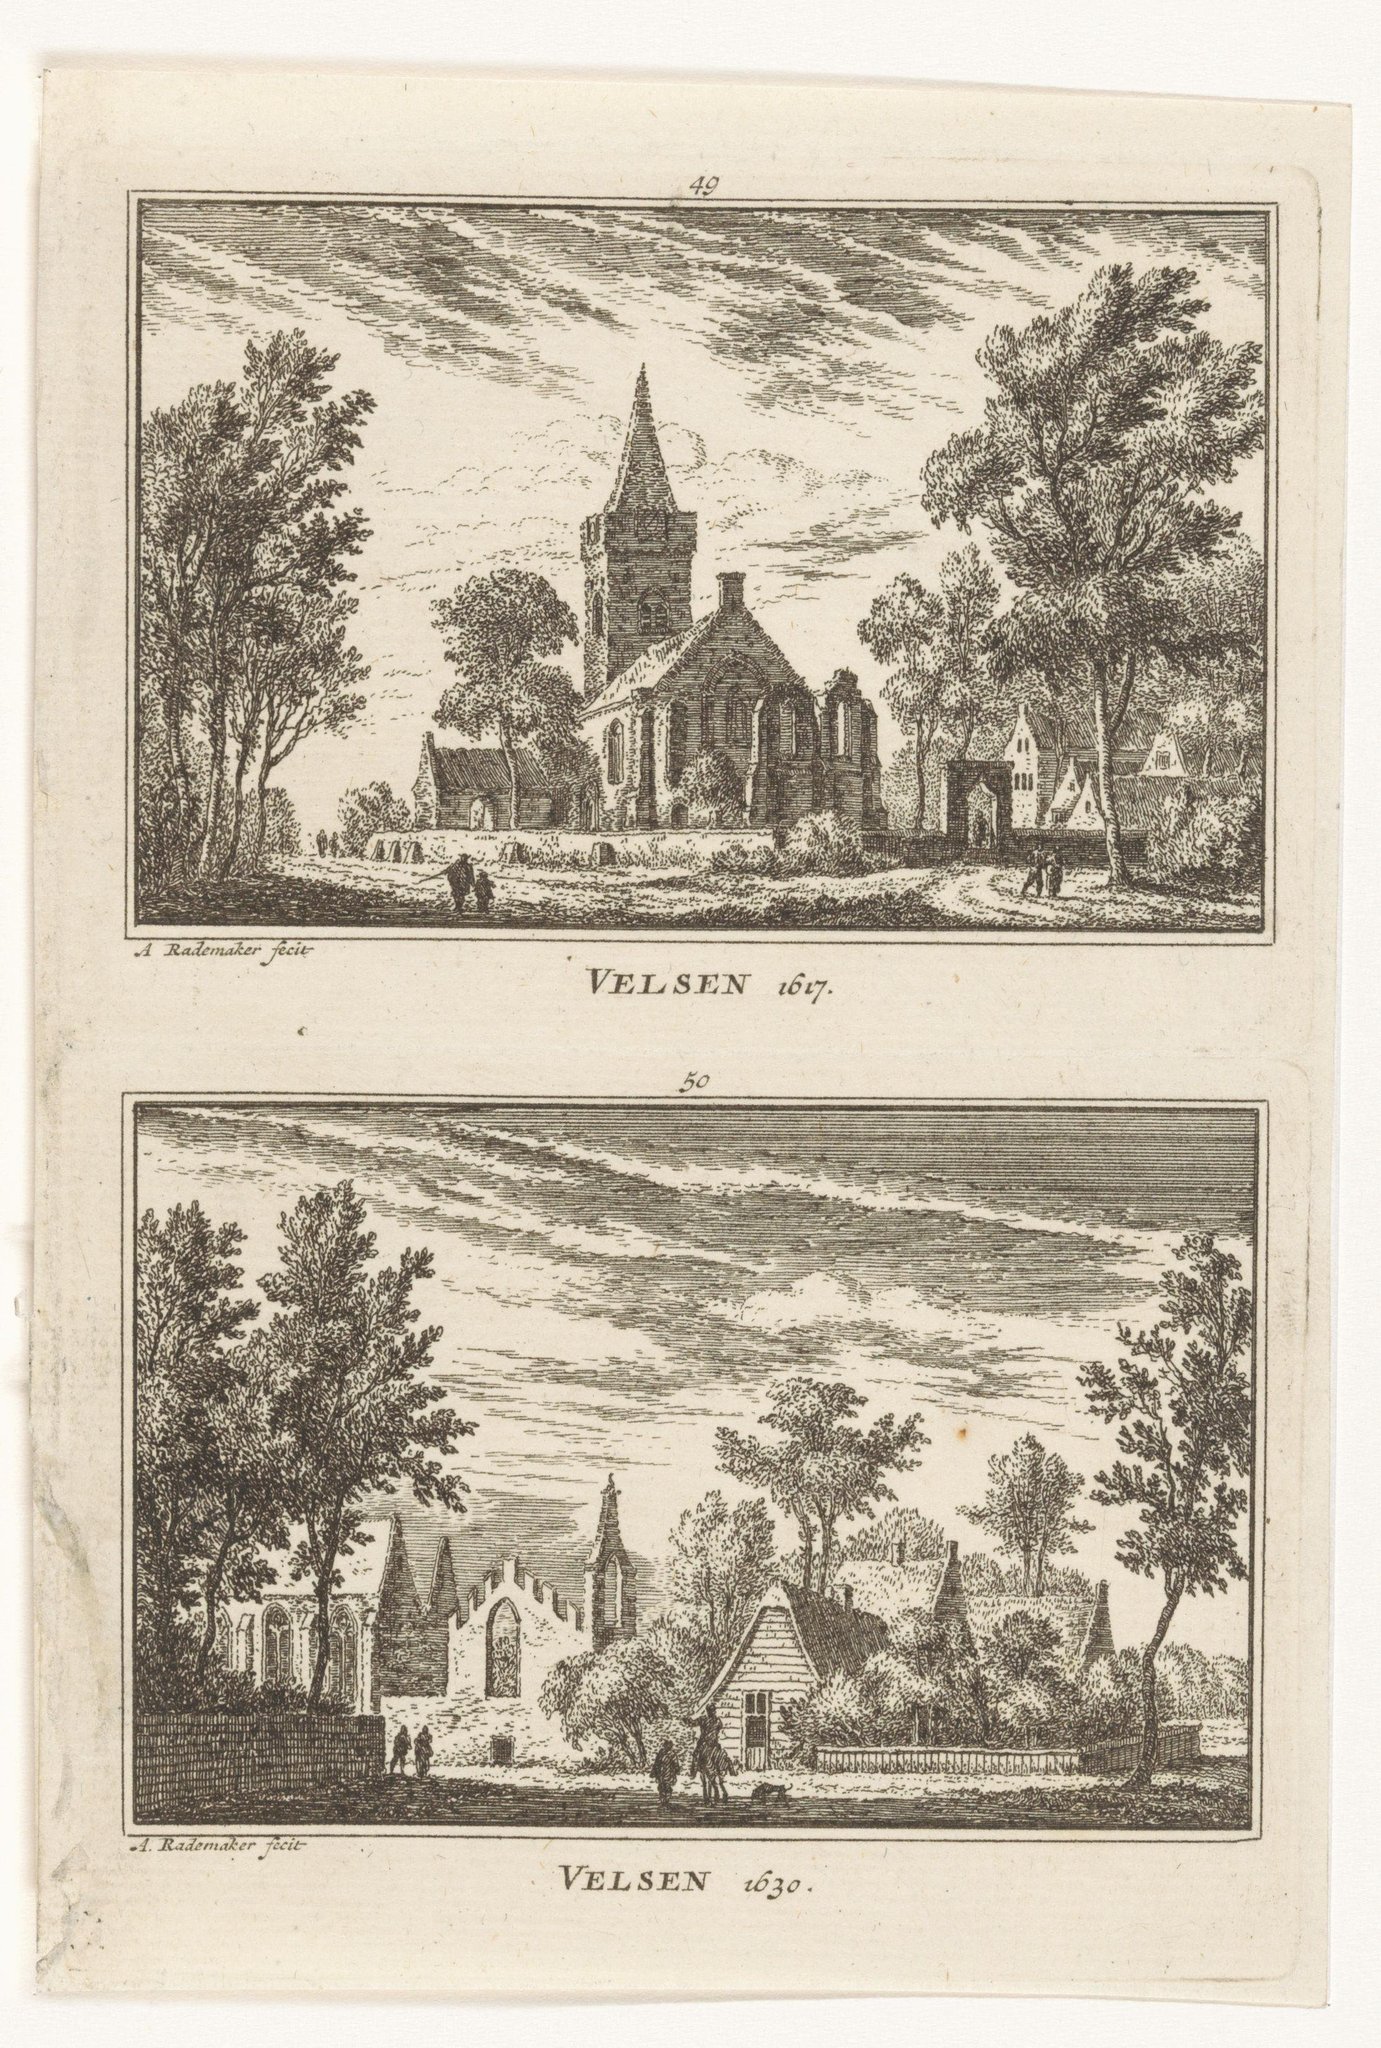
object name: print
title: Velsen 1630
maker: abraham rademaker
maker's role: draughtsman, print maker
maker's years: 1676-1735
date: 1725-1803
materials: paper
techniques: engraving, etching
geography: amsterdam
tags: prospect of village, silhouette of village, church (exterior), ruin of church, monastery, etc.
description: Prent ook gebruikt in: Rademaker, Abraham. Kabinet van Nederlandsche outheden en gezichten: vervat in 300 konstplaaten (…). 2 delen. Amsterdam: Willem Barents, 1725, dl. 1, ill. 49 en 50. Na 1725 is deze prent nog in verschillende heruitgaven verschenen, uitgegeven in 1727-1733, 1770-1771 en 1792-1803. Uit welke uitgave het huidige exemplaar precies komt is niet na te gaan.